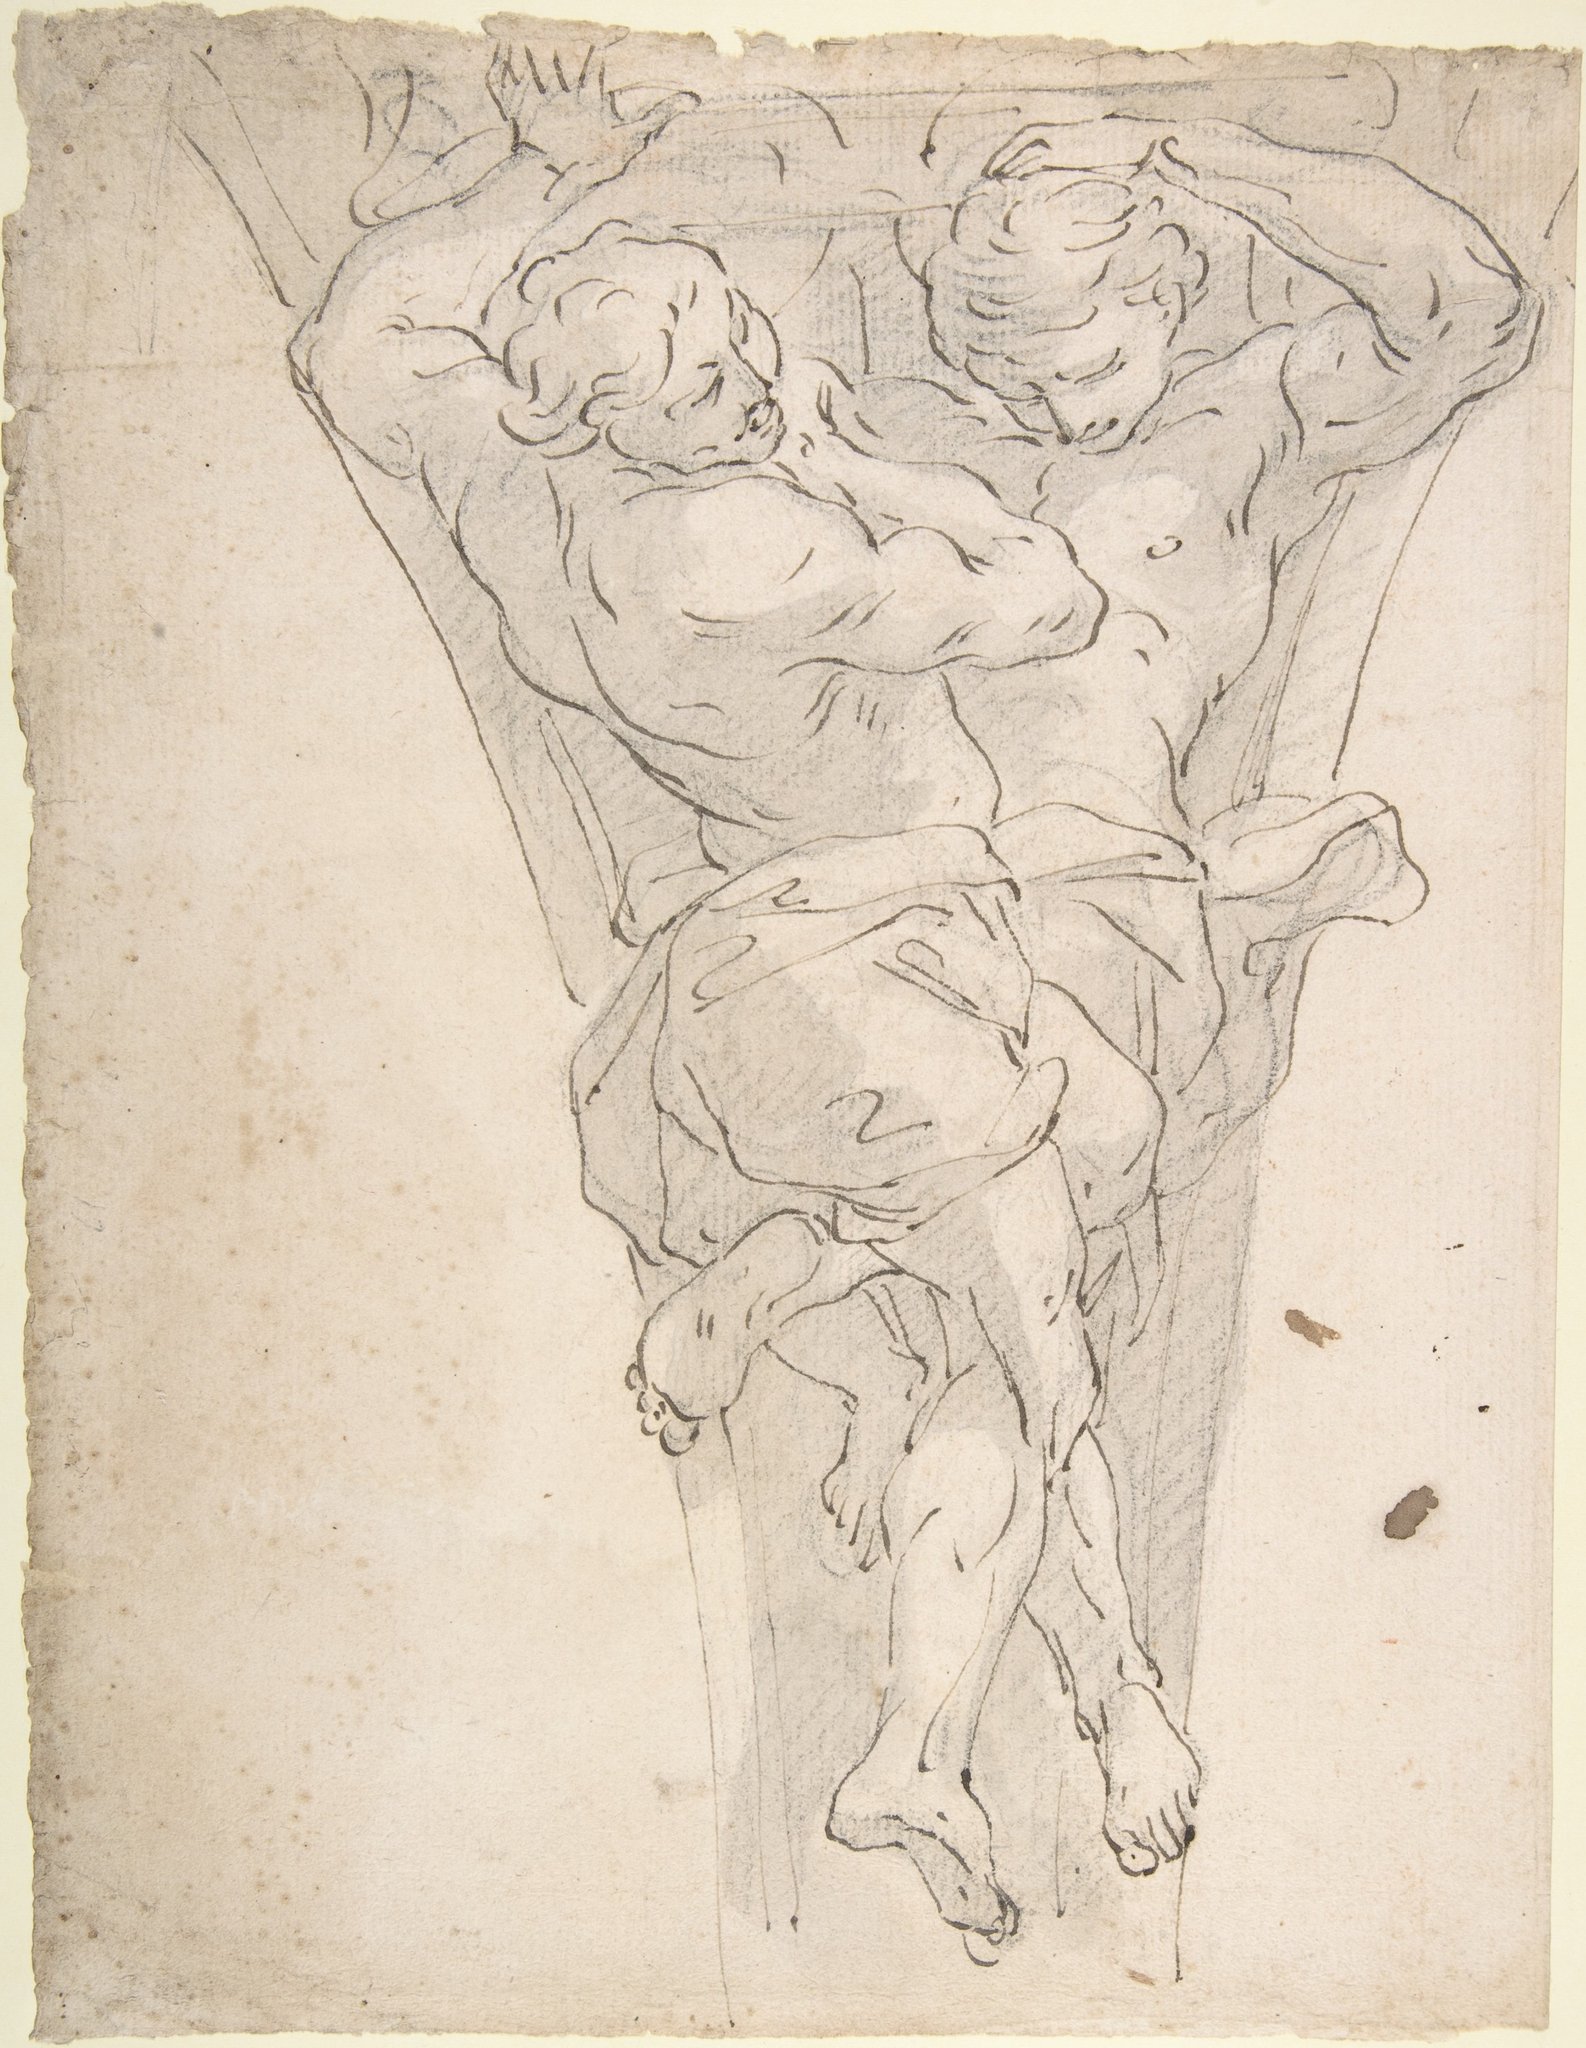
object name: drawing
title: Two Partially Draped Male Figures in a Pendentive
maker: giovanni battista carlone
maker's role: artist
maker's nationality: italian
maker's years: 1603-1684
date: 1603-1684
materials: chalk, ink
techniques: brush, pen, wash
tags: men